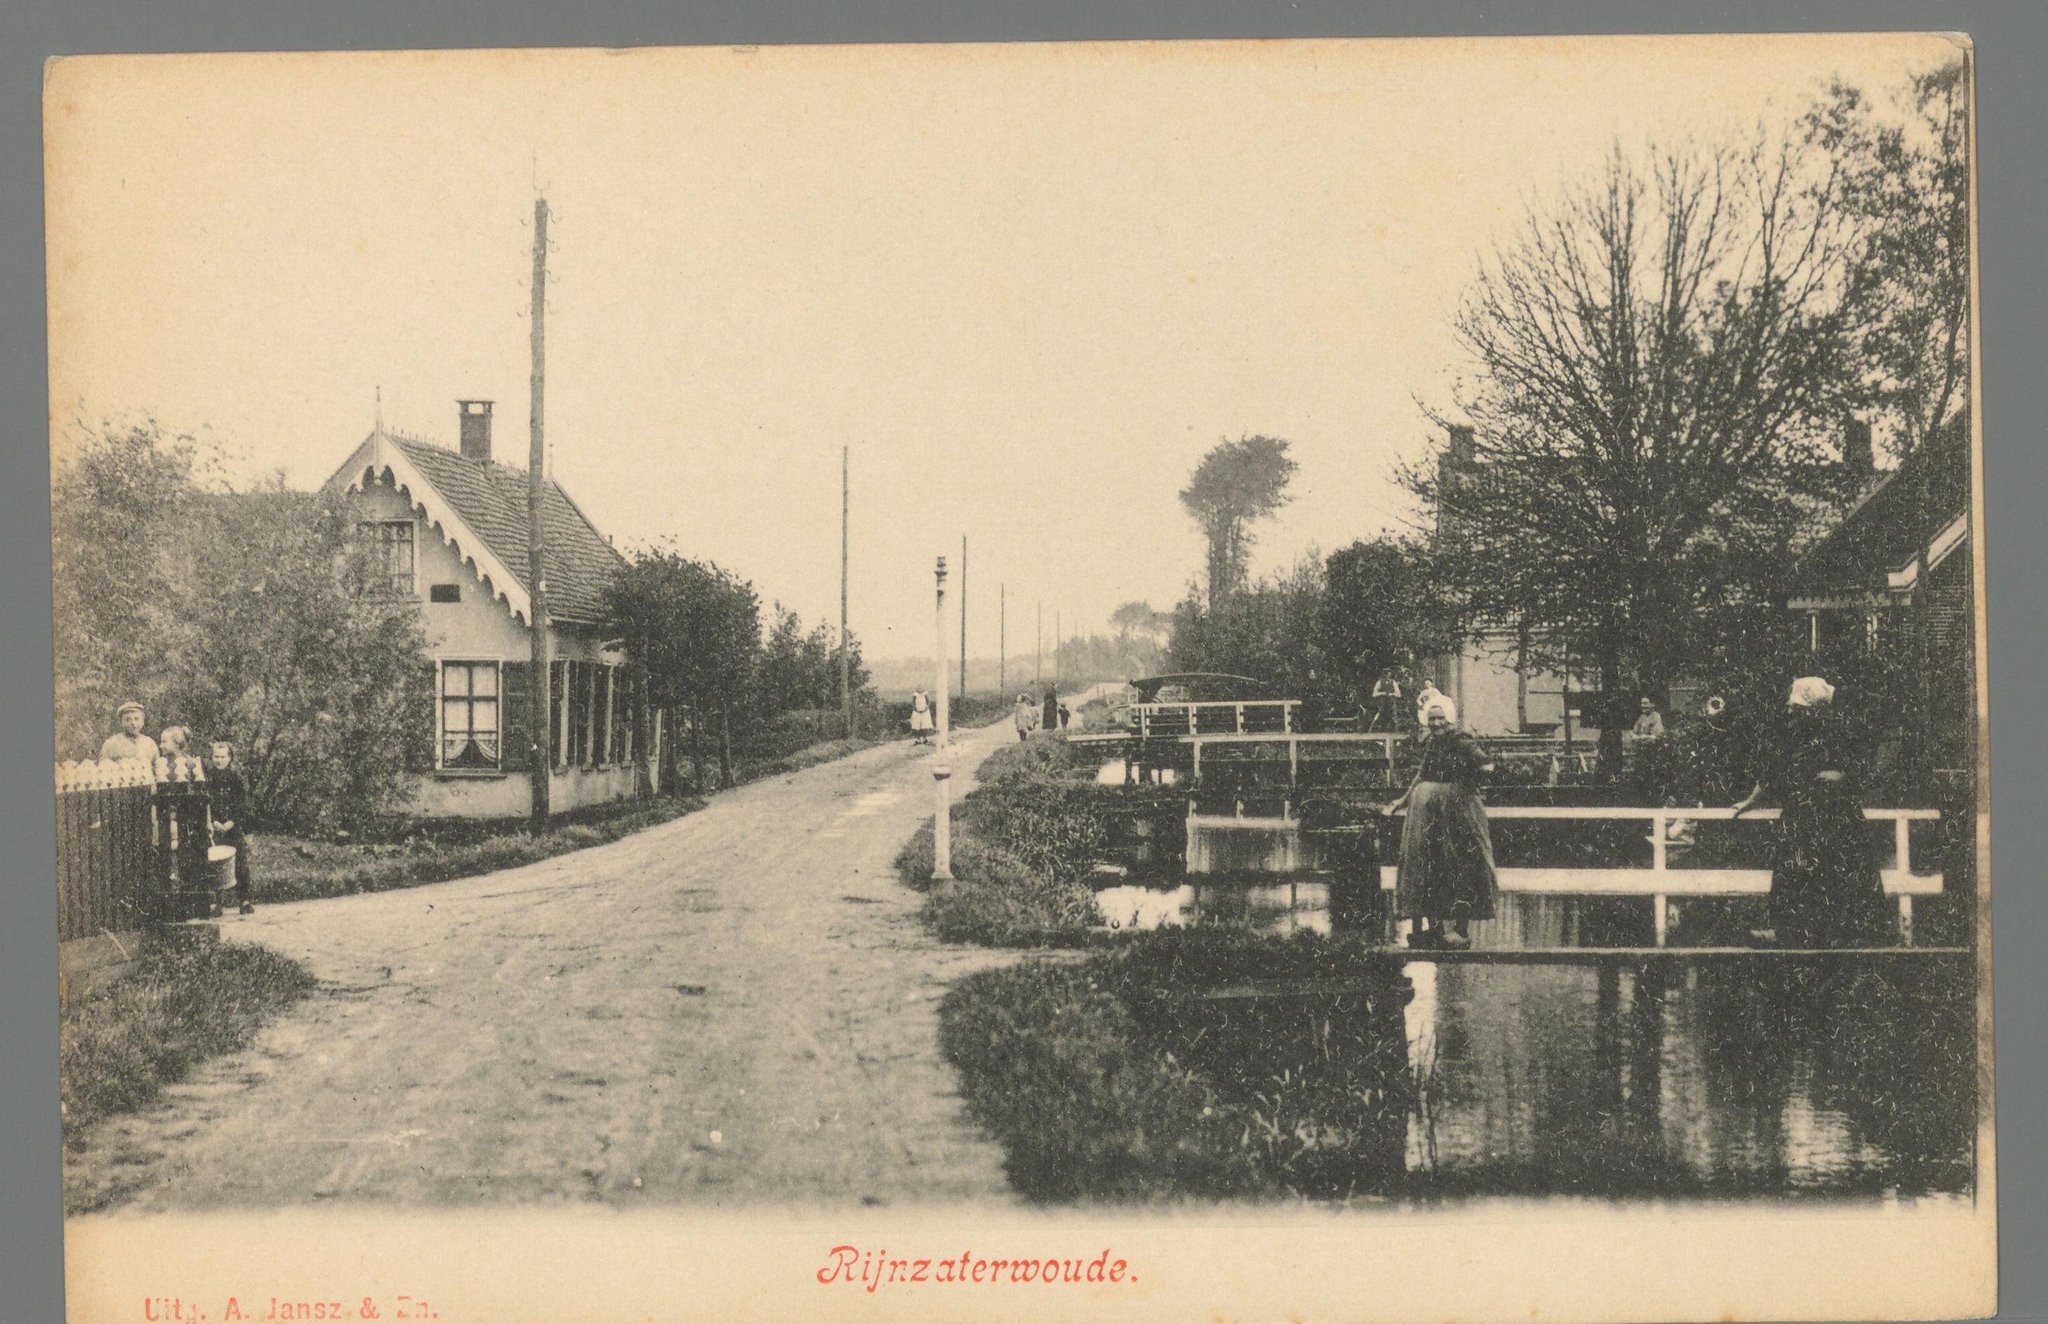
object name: photomechanical print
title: Rijnzaterwoude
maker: Anonymous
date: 1897-1905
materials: cardboard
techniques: photograph, writing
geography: rijnsaterwoude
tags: canals, waters (in village), street, bridge in village across river, canal, etc.